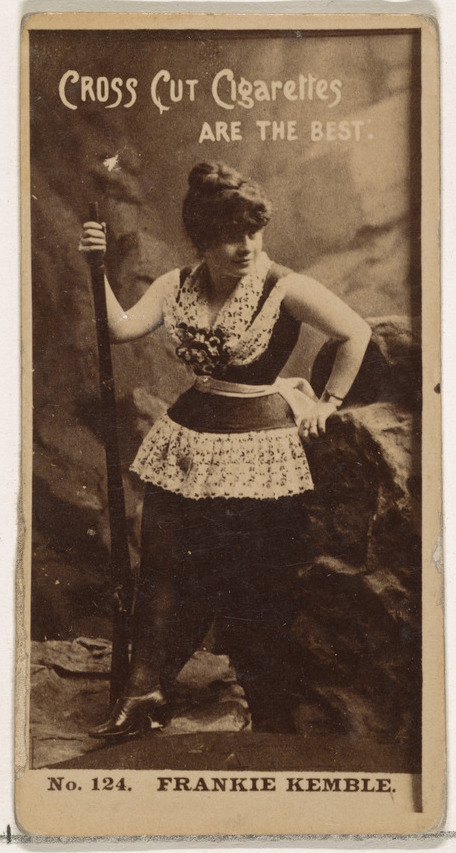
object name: print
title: Card Number 124, Frankie Kemble, from the Actors and Actresses series (N145-2) issued by Duke Sons & Co. to promote Cross Cut Cigarettes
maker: w. duke, sons & co.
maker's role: publisher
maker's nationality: american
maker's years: 1870-1920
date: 1880-1889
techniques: albumen silver print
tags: portraits,women,actresses